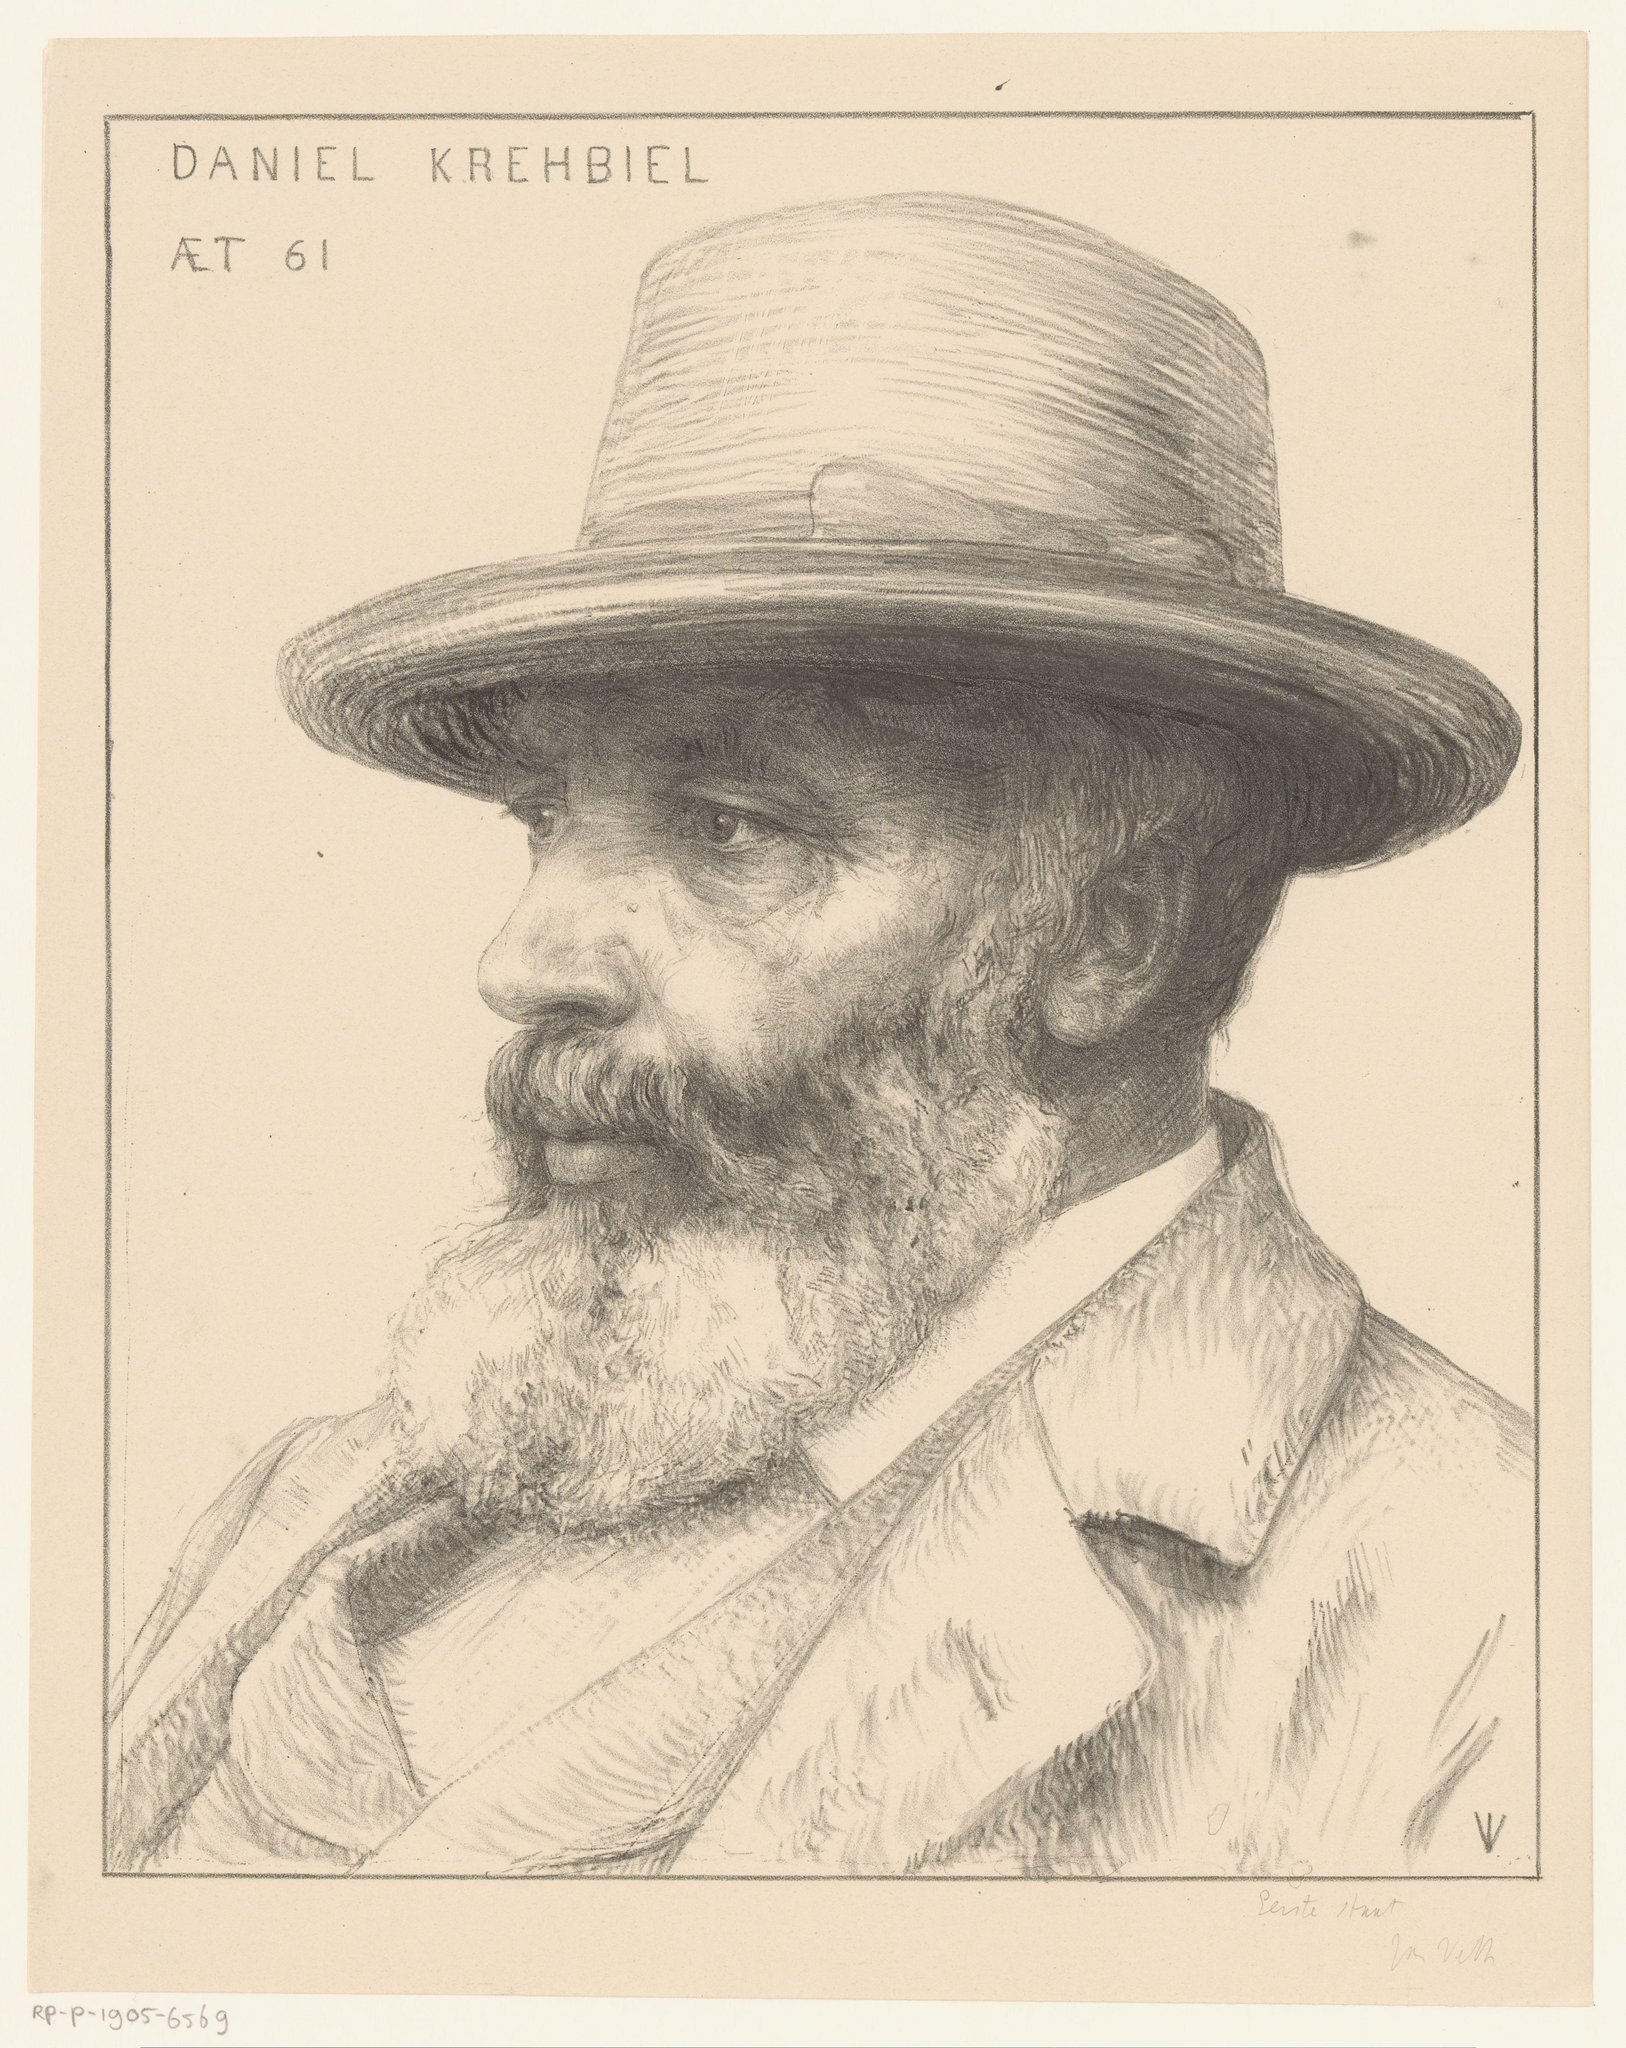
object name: print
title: Portret van Daniel Krehbiel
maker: jan veth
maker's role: designer, draughtsman, painter, print maker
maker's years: 1864-1925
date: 1904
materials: paper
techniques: lithograph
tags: historical persons (+ (full) bust portrait)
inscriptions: collector's mark: Lugt 2228, inscription: ‘Eerste Staat / Jan Veth’